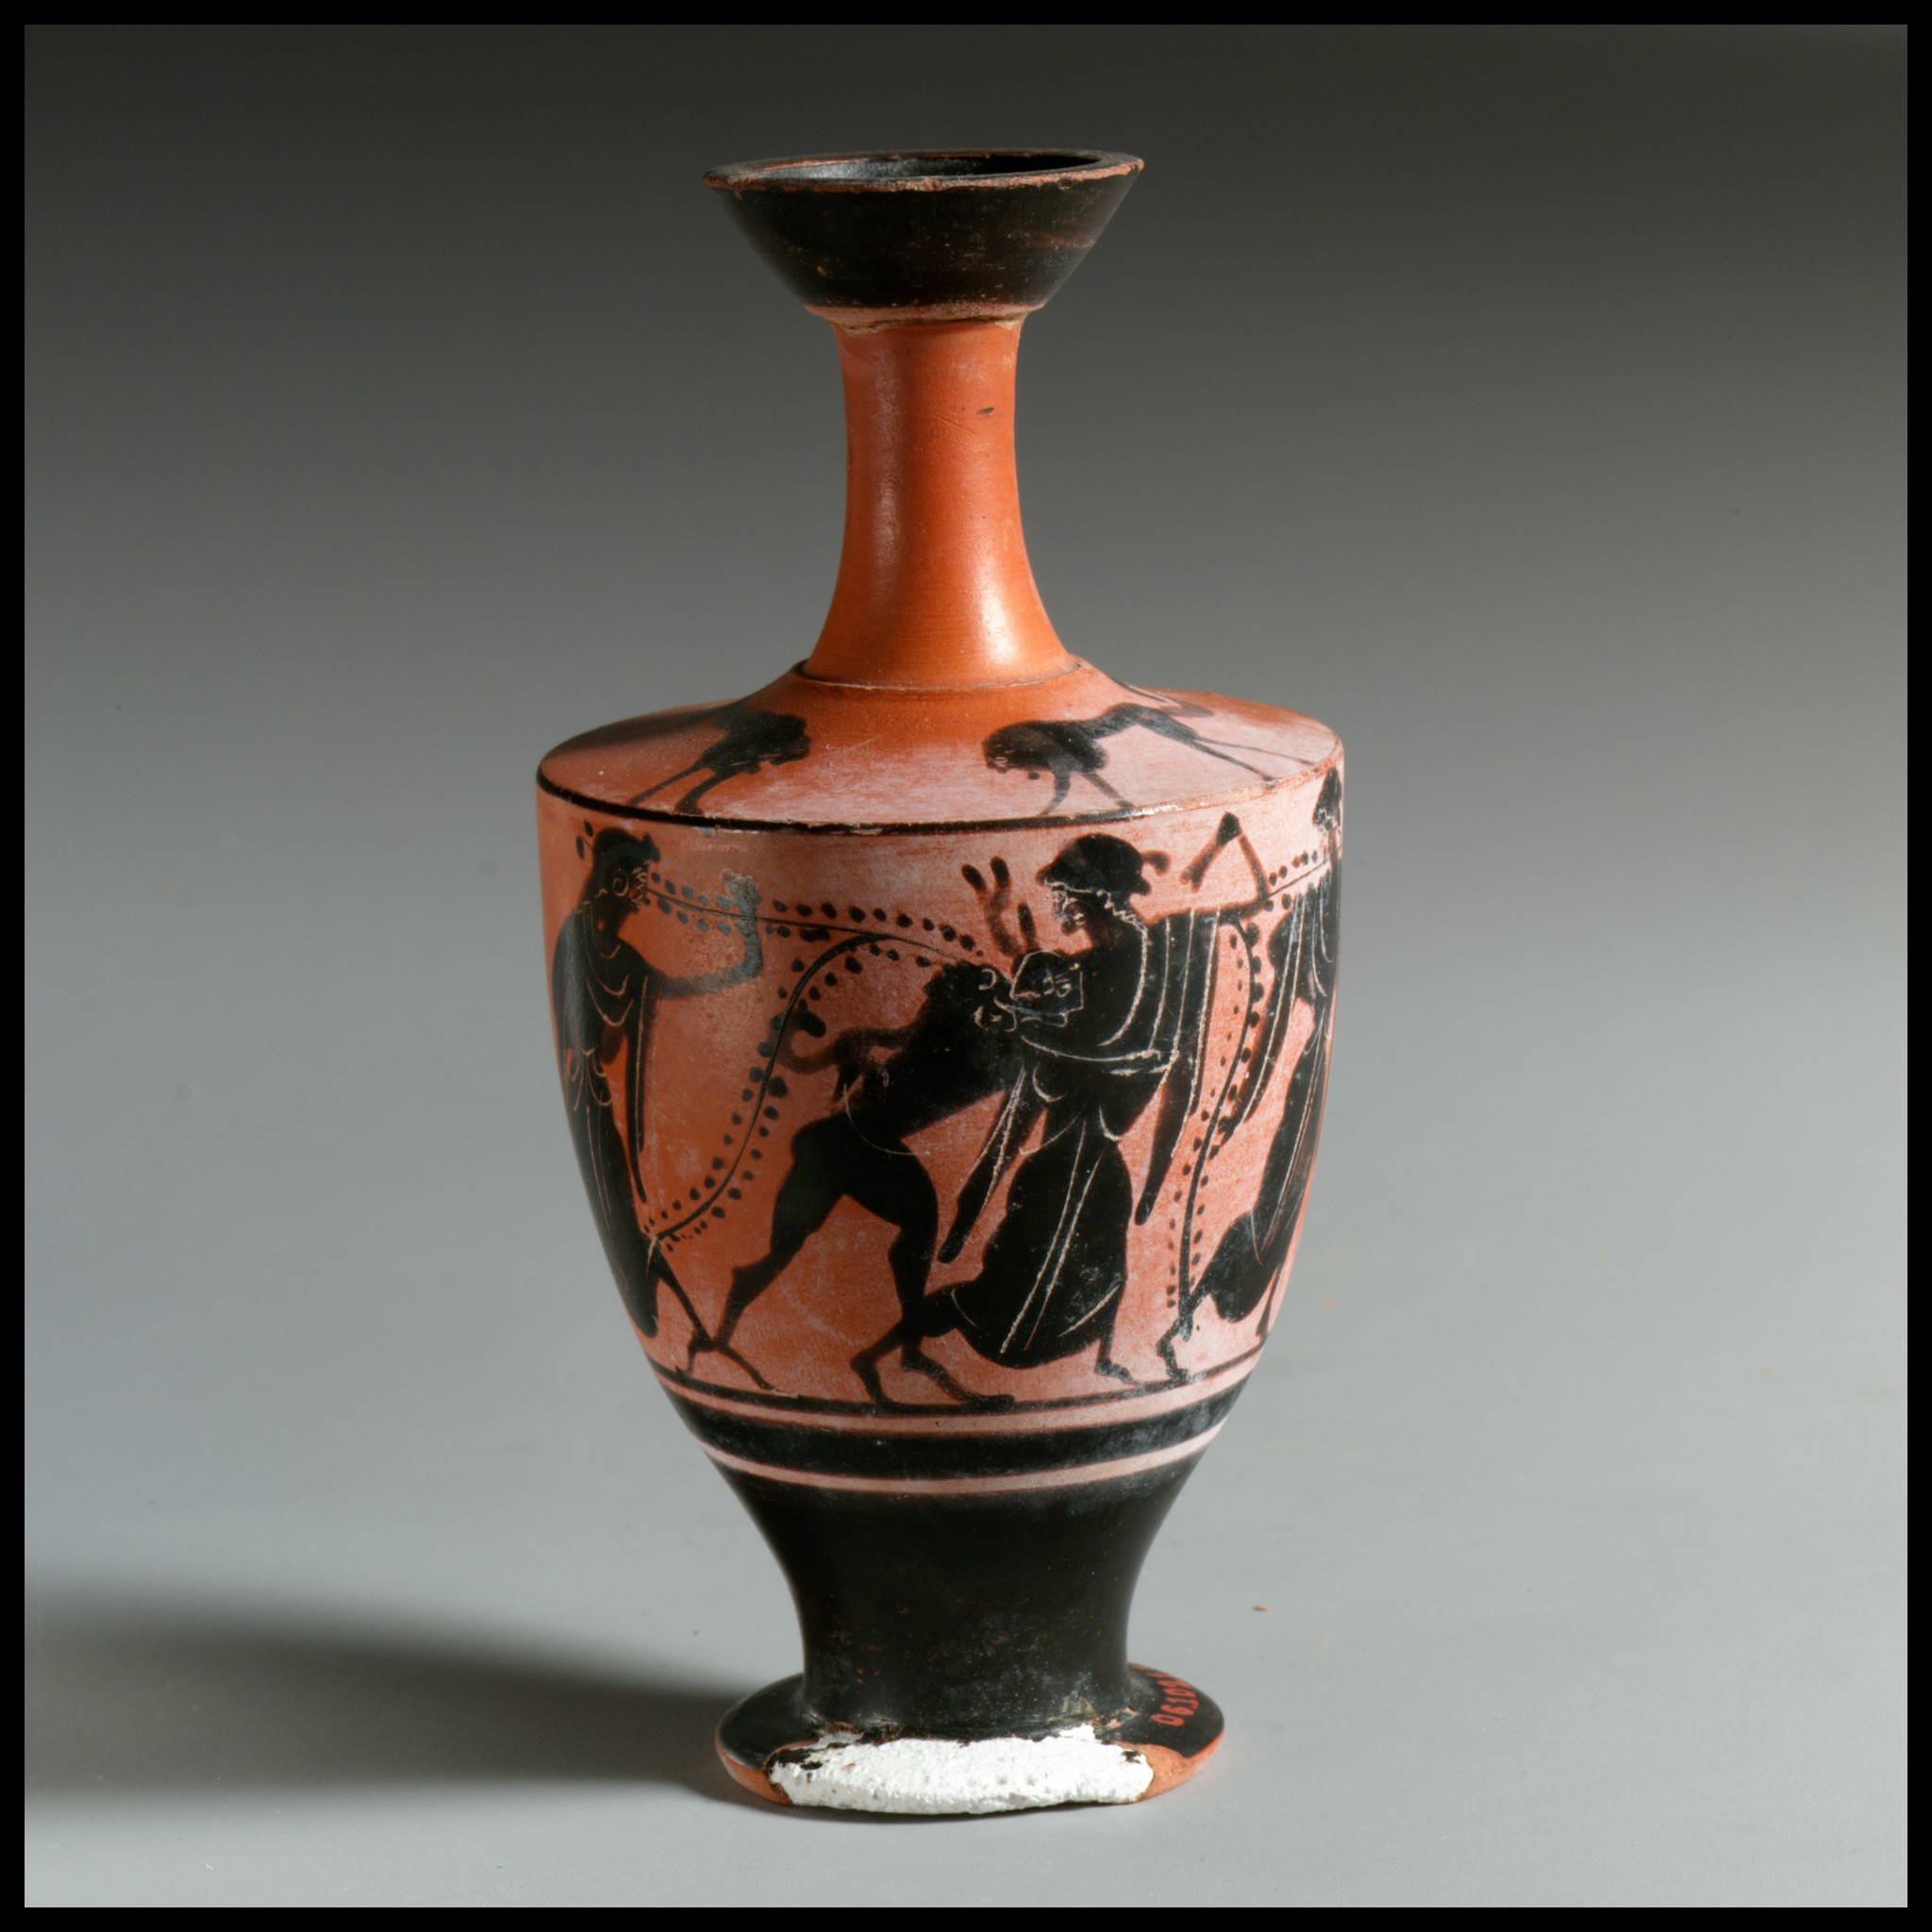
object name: lekythos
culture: greek, attic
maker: krotala painter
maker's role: artist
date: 500-490 BCE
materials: terracotta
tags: human figures,lions